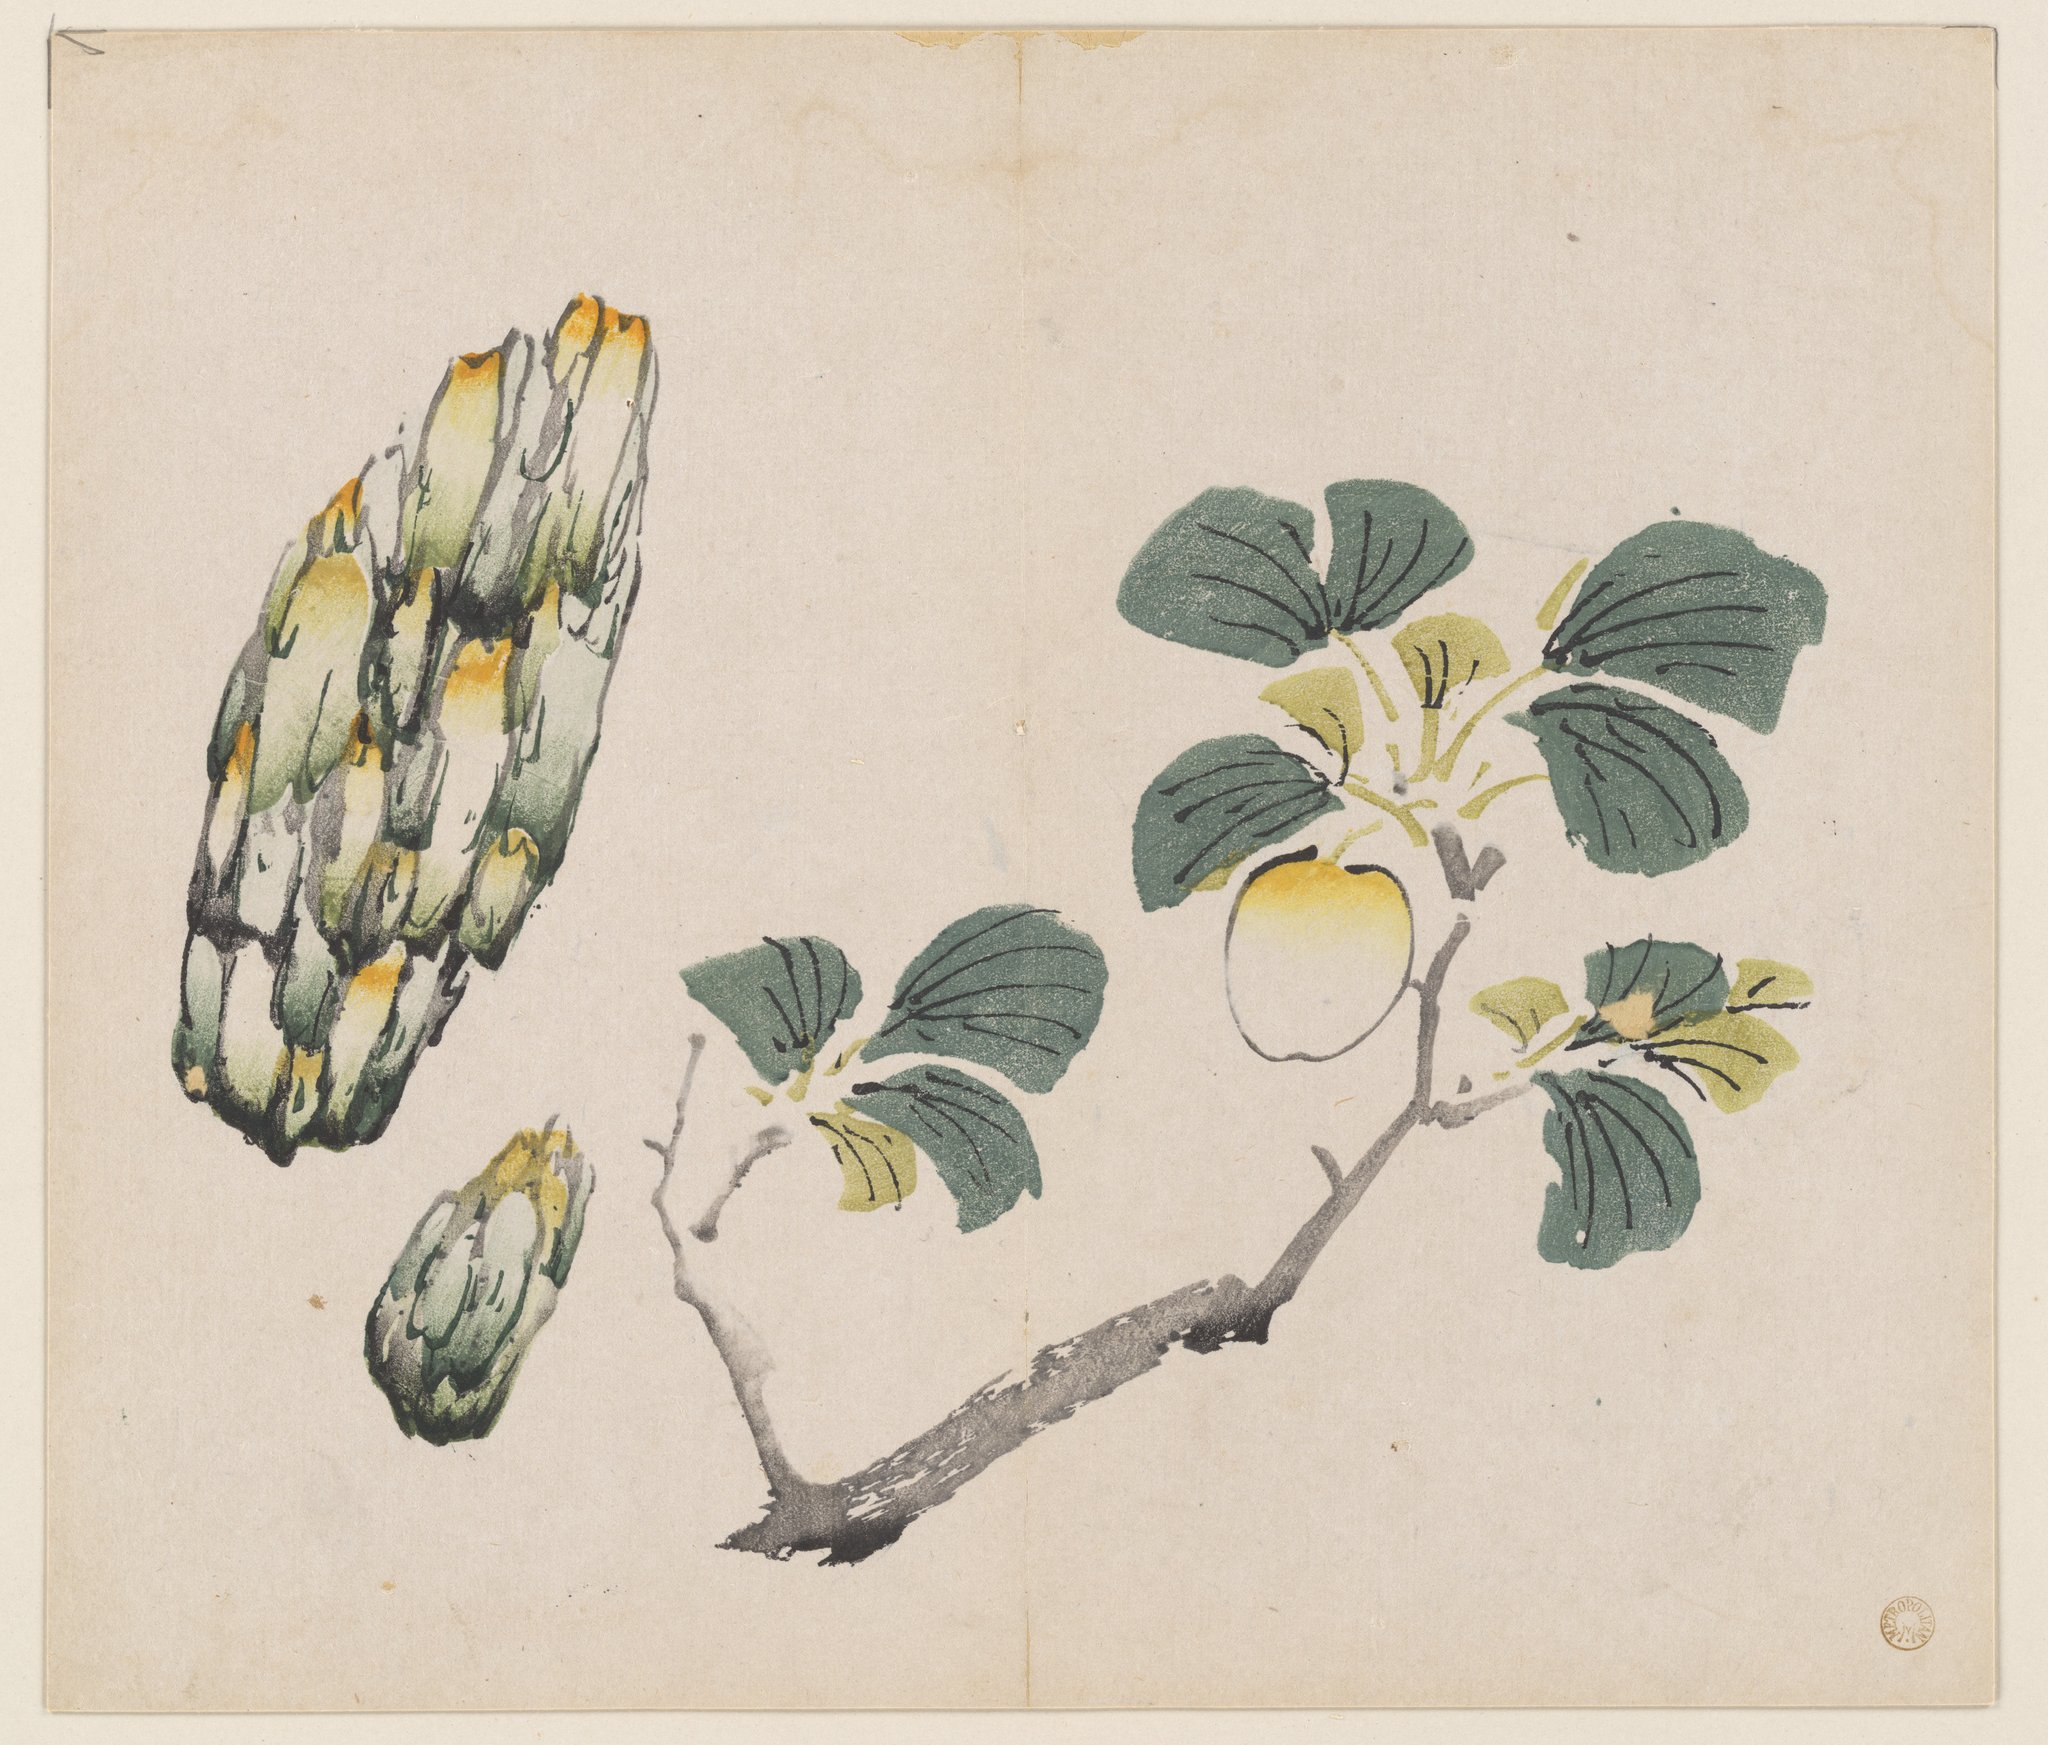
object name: print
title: Page from the Ten Bamboo Studio Manual of Painting and Calligraphy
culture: chinese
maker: hu zhengyan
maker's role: artist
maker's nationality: chinese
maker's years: 1584-1634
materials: ink, paper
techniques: printing